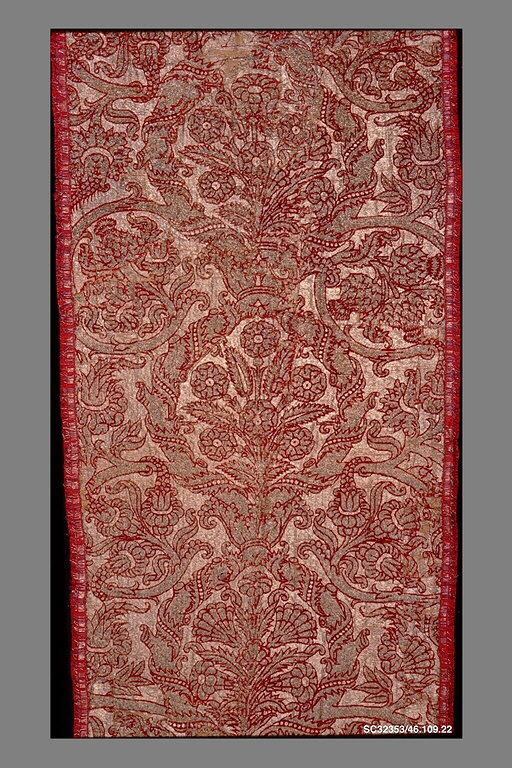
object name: piece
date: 1480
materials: metal thread, silk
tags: flowers